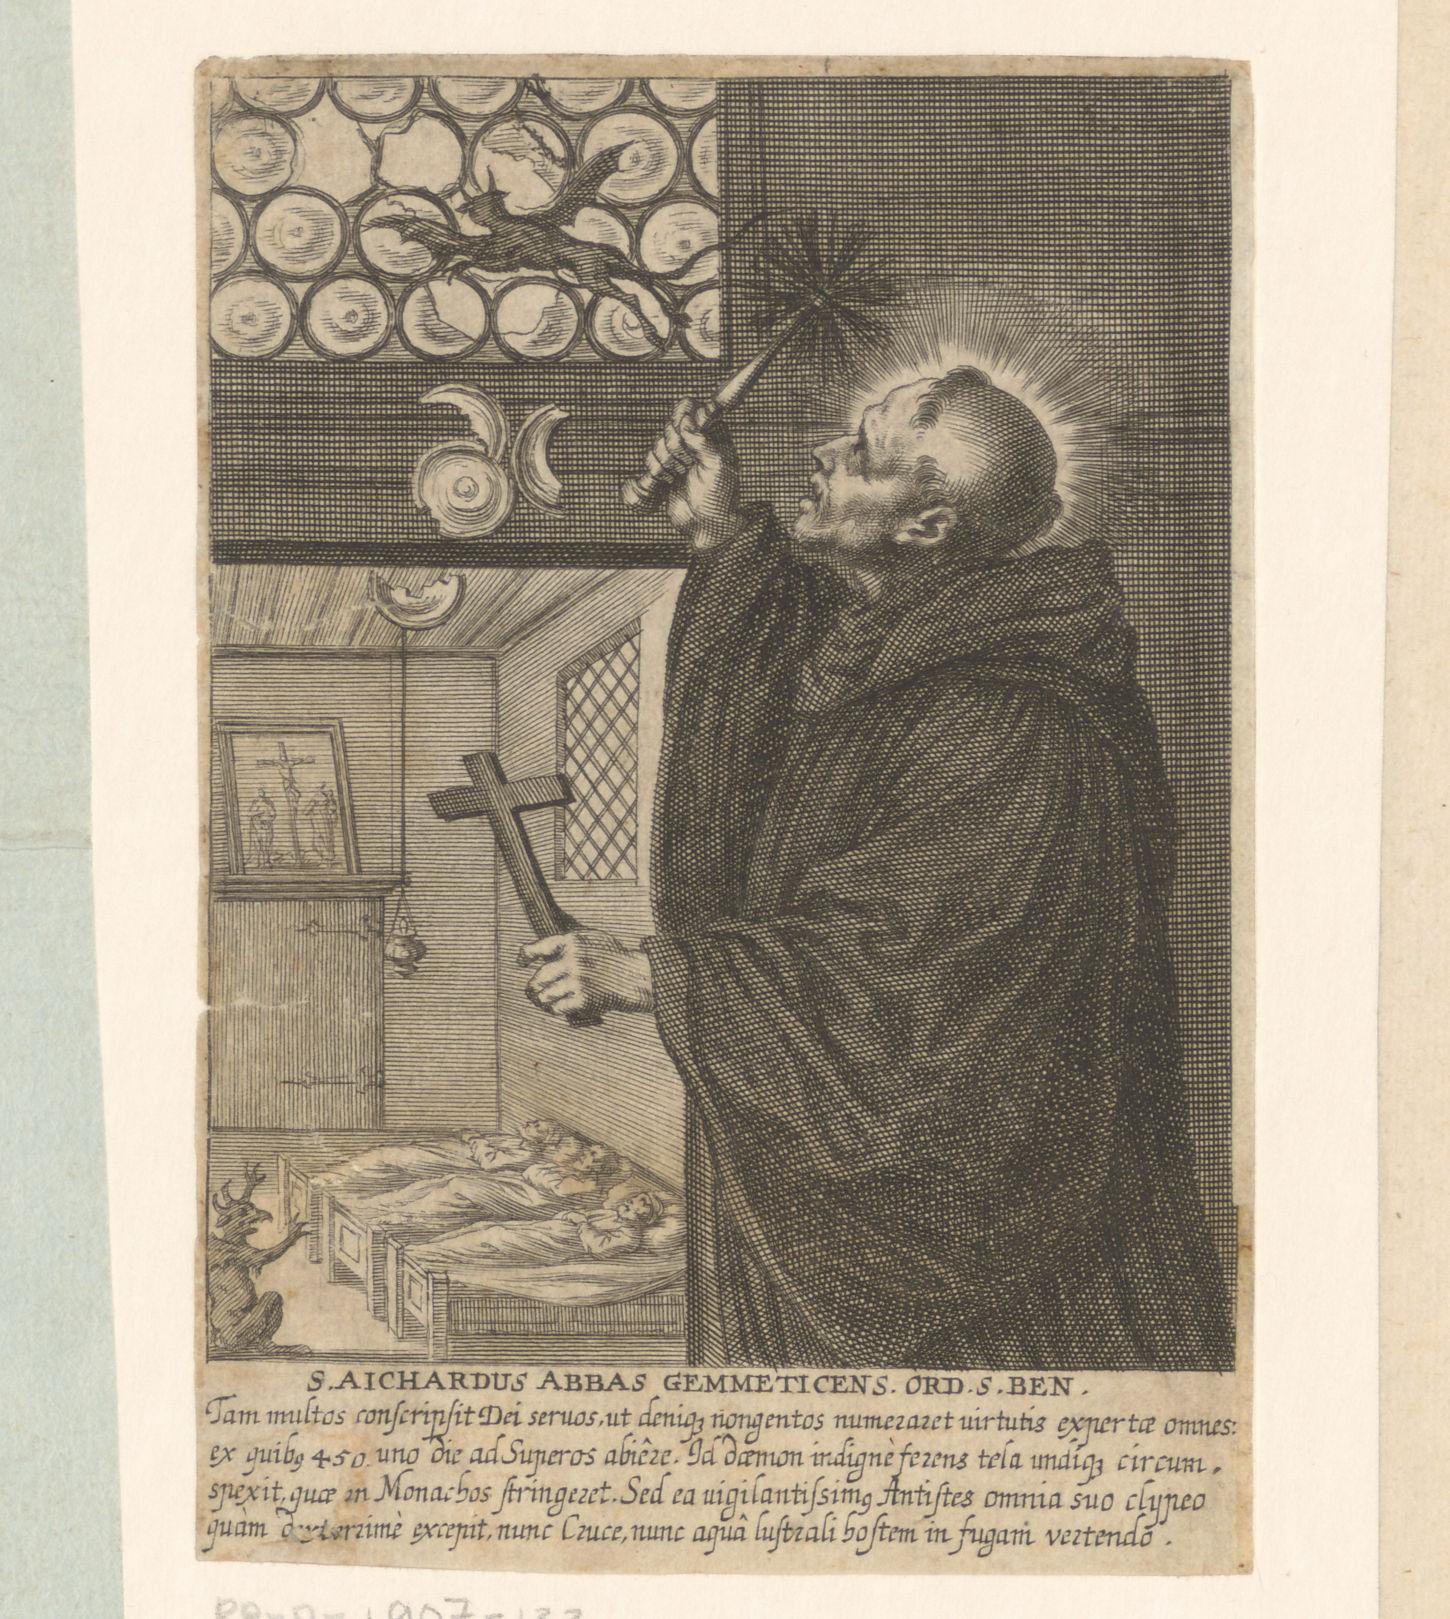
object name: print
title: H. Aichardus verdrijft duivelse wezens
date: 1640-1696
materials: paper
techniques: engraving, etching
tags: devils in other than human or animal form, saints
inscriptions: collector's mark: Lugt 2228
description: In de marge onderaan vier regels tekst in het Latijn over deze Benedictijner monnik.